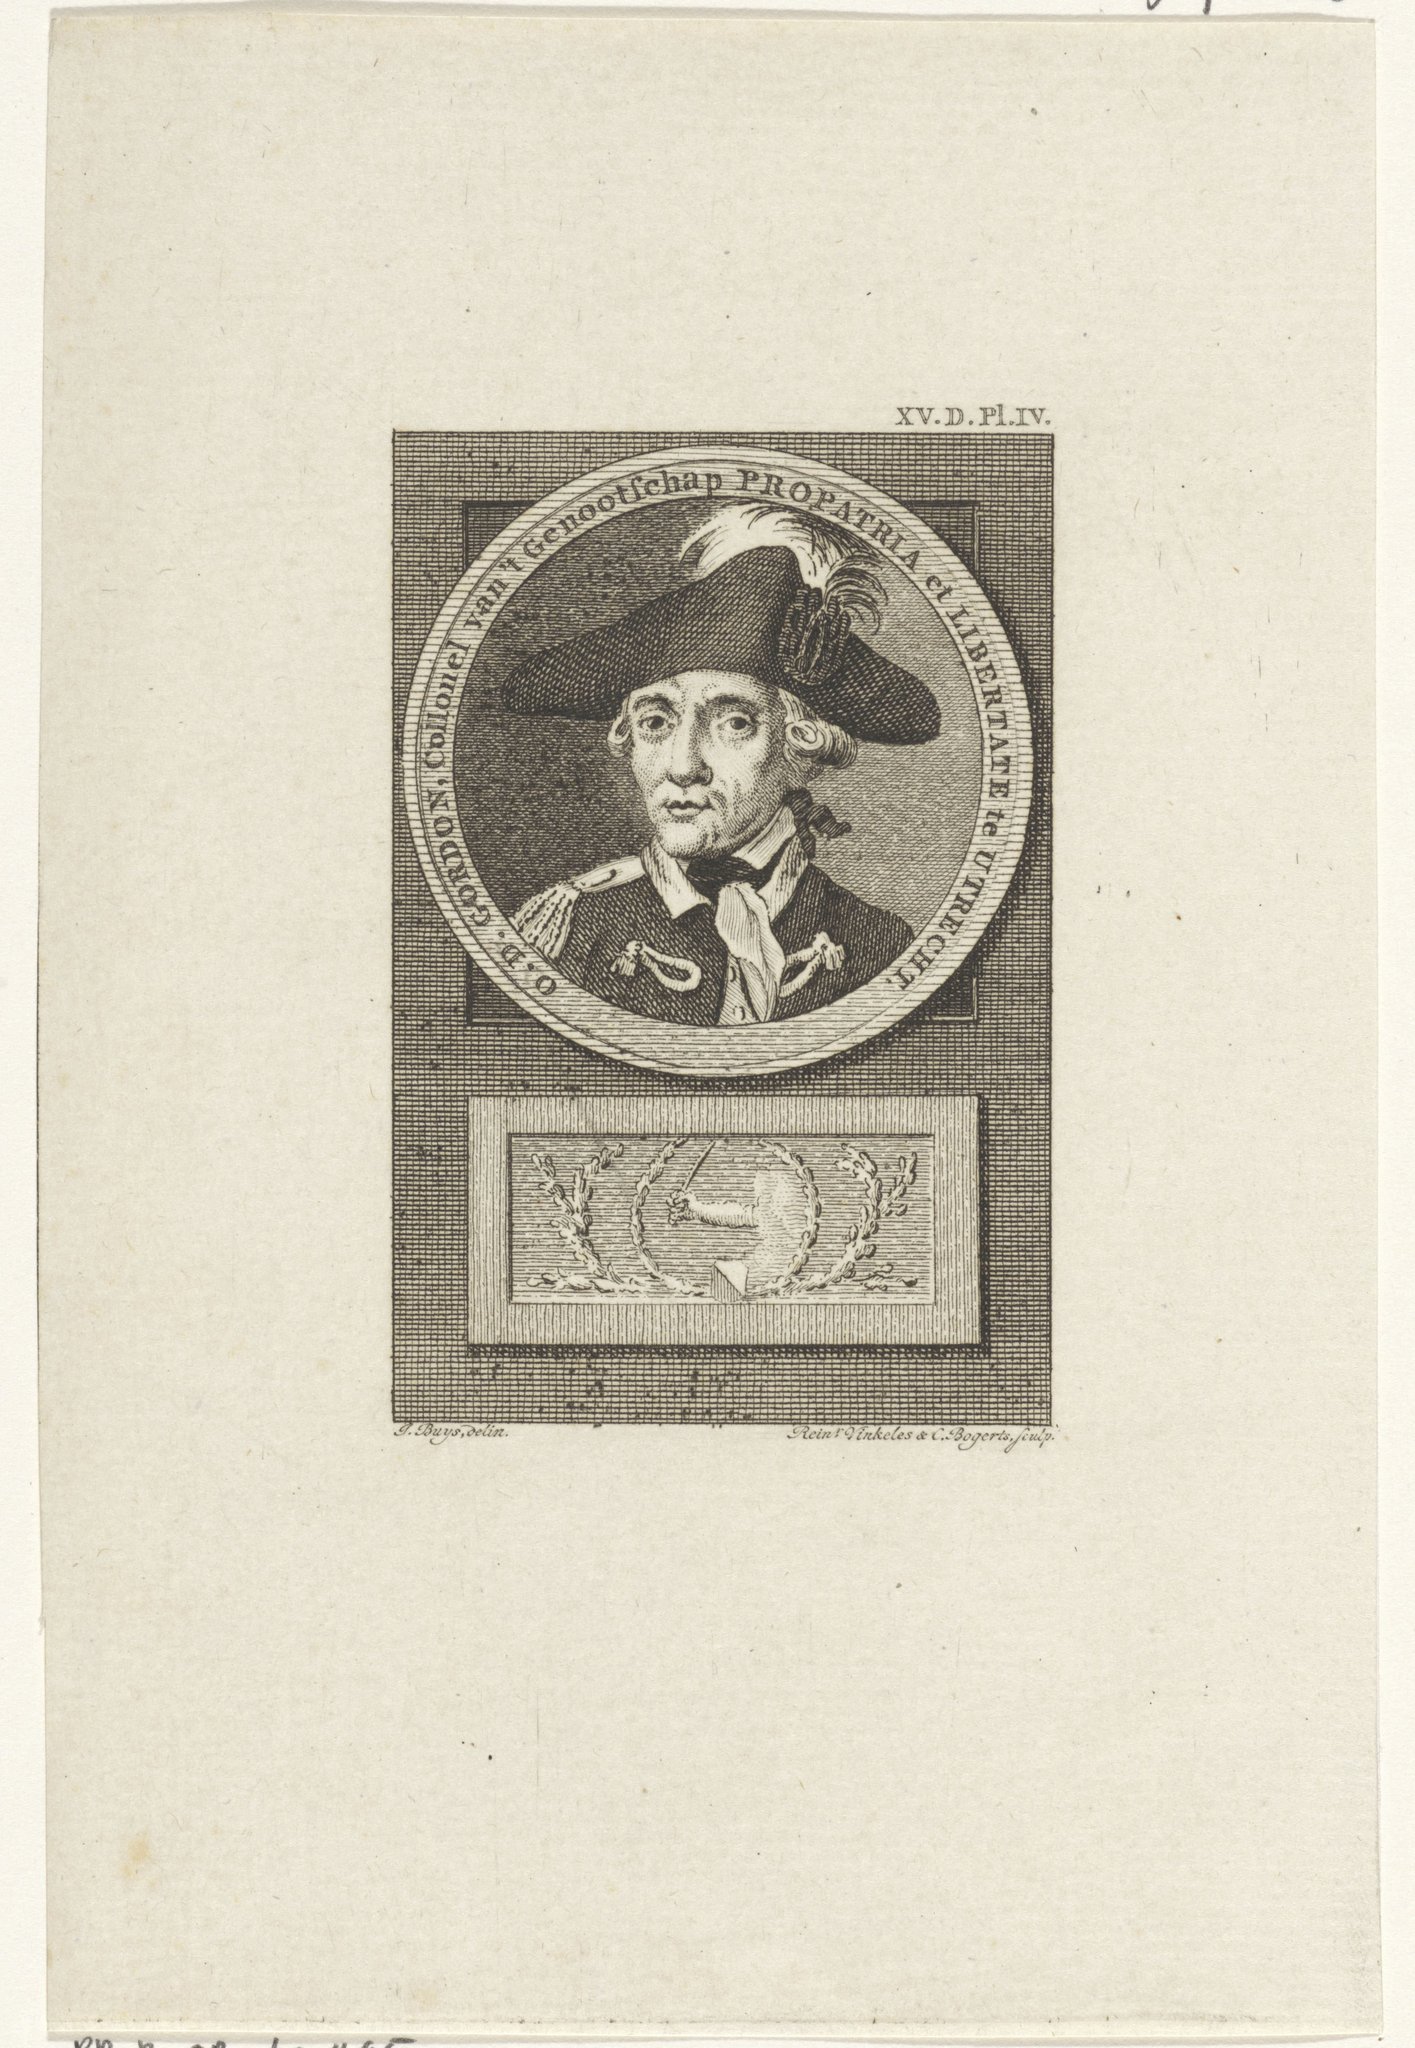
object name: print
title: Portret van Otto Derk Gordon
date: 1783-1795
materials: paper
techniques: engraving, etching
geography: amsterdam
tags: utrecht, otto derk gordon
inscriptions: collector's mark: Lugt 2228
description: Prent gebruikt in: Fokke, Jan. Geschiedenissen der Vereenigde Nederlanden voor de vaderlandsche jeugd Ie-XXVste deel. Amsterdam: Johannes Allart, 1783-1795. Deel XV.